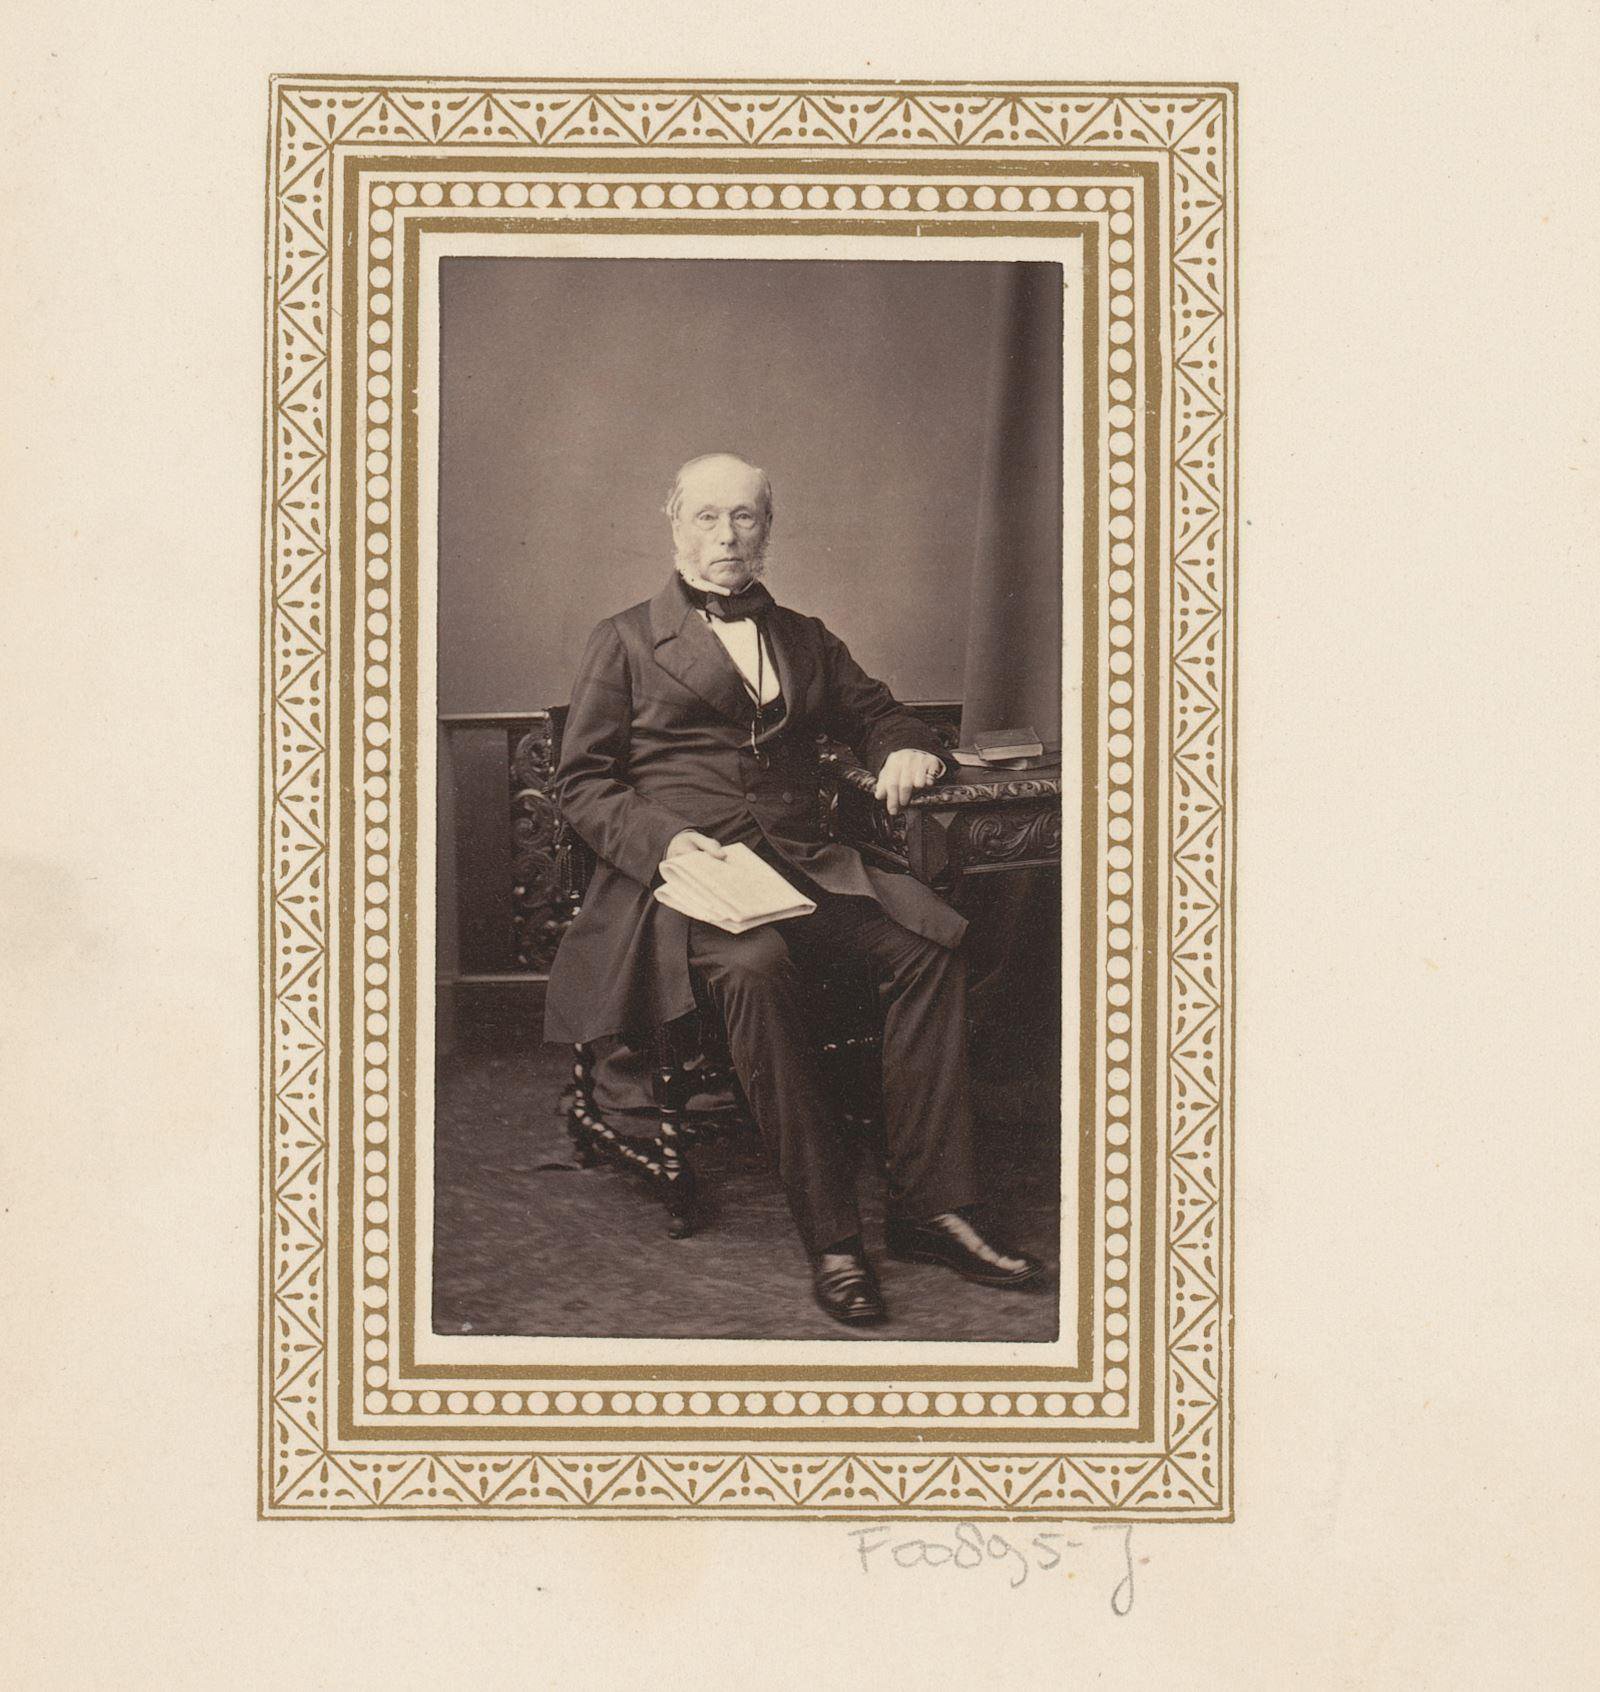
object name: carte de visite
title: Portret van een zittende man met een krant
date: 1867-1875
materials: cardboard, photographic support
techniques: albumen print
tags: sitting figure, adult man, historical persons, newspaper, news-sheet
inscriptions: inscription: ‘G & R Lavis/ Photographers & Minature Painters/ 135 Regent Street/ W.’